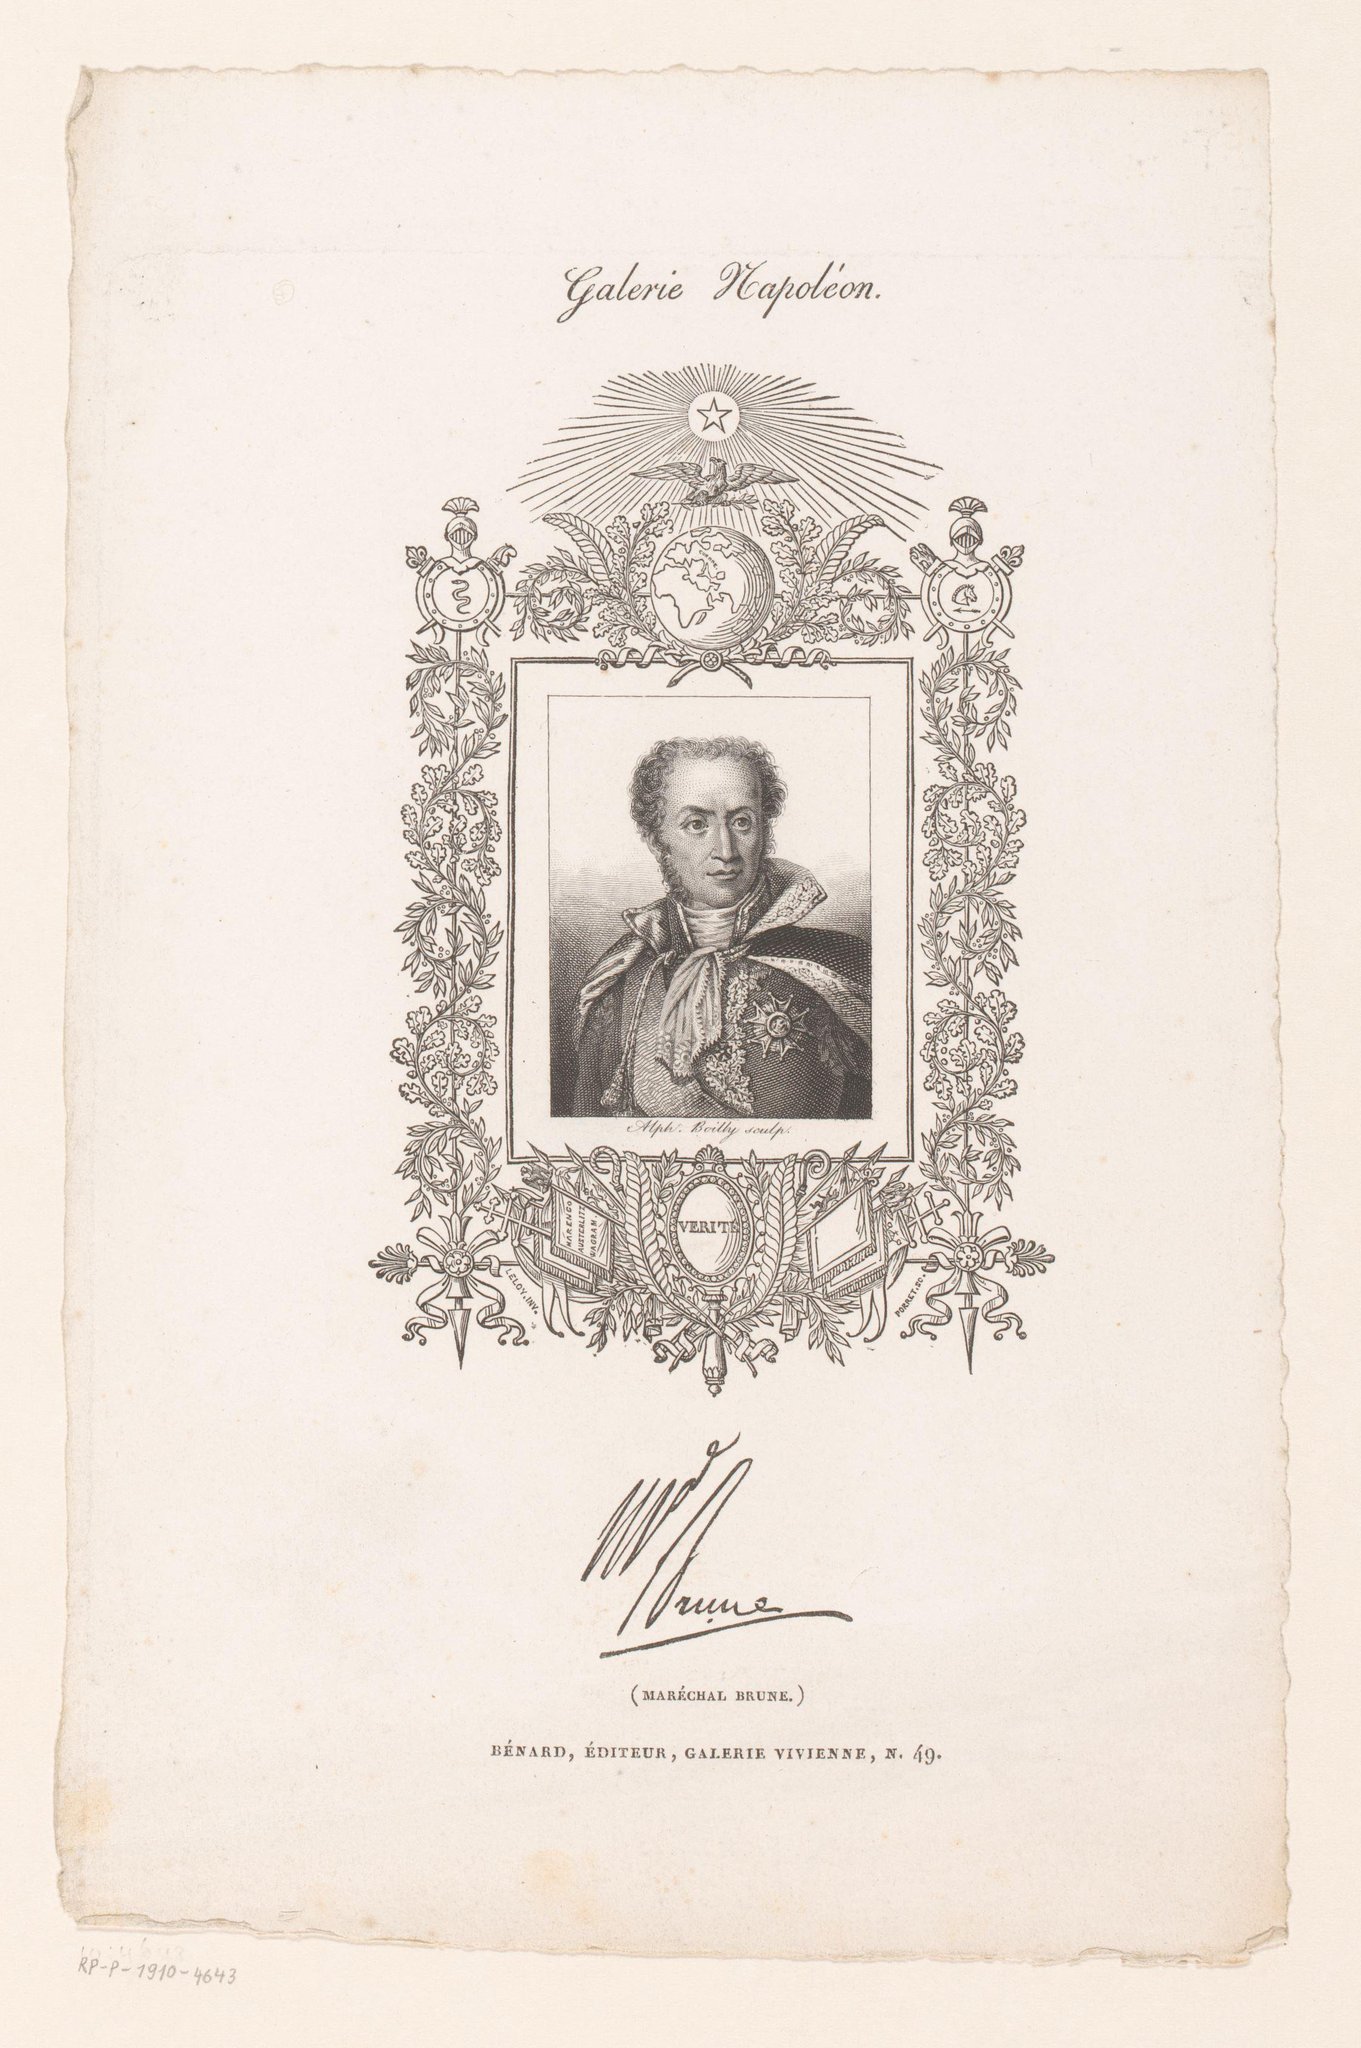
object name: print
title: Galerie Napoléon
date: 1811-1867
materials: paper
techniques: engraving, etching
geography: france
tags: historical persons, ornament ~ cartouche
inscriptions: collector's mark: Lugt 2228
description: Dit portret maakte deel uit van de serie "Galerie Napoléon", een collectie van honderd portretten van vooraanstaande figuren uit de omgeving van Napoleon Bonaparte. De serie werd uitgegeven door Bénard in Parijs in 1829-30.